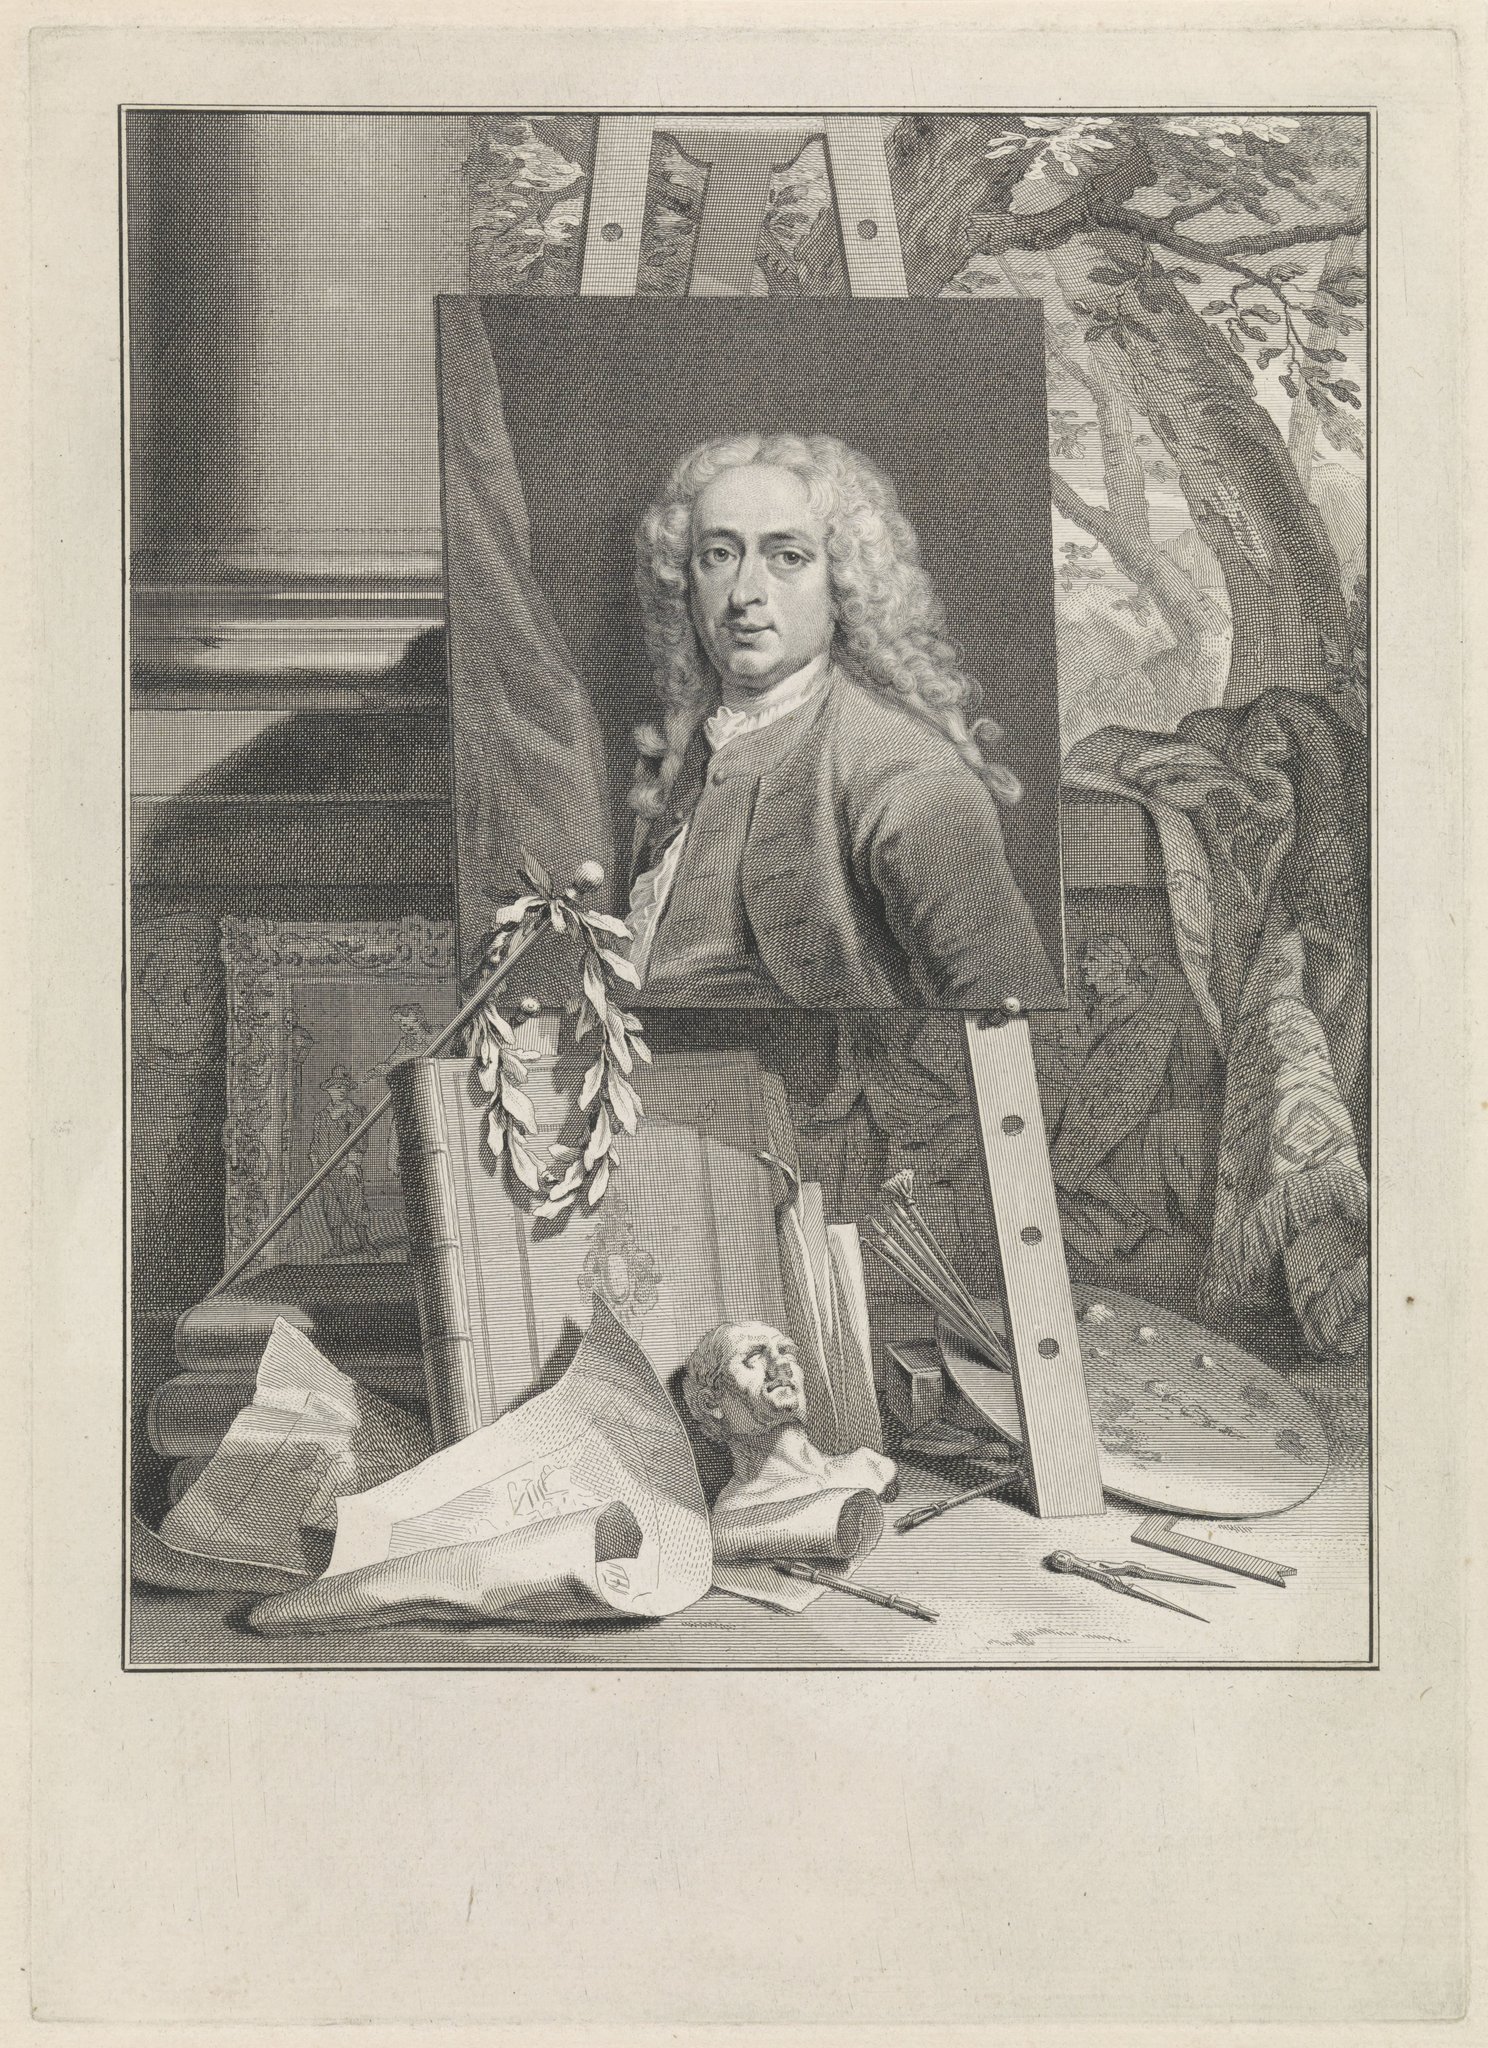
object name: print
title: Portret van Cornelis Troost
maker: jacob houbraken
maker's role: draughtsman, print maker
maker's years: 1698-1780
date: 1760-1780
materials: paper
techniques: engraving, etching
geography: amsterdam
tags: amsterdam, painter, print maker, draughtsman, cornelis troost, historical persons, portrait, self-portrait of painter, tools, implements of painter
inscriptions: collector's mark: Lugt 240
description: Portret naar links van de schilder Cornelis Troost. Het schilderij met zijn portret staat op een schildersezel op een bordes en is omringd door de attributen van de schilder- en graveerkunst. Onder de ezel liggen palet en penselen, een gebeeldhouwde kop, tekenstiften, boeken en tekeningen. Links staat de schildersstok, waaraan een lauwerkrans hangt. Daarachter een schilderij in lijst. In de achtergrond een doorkijk naar een landschap.